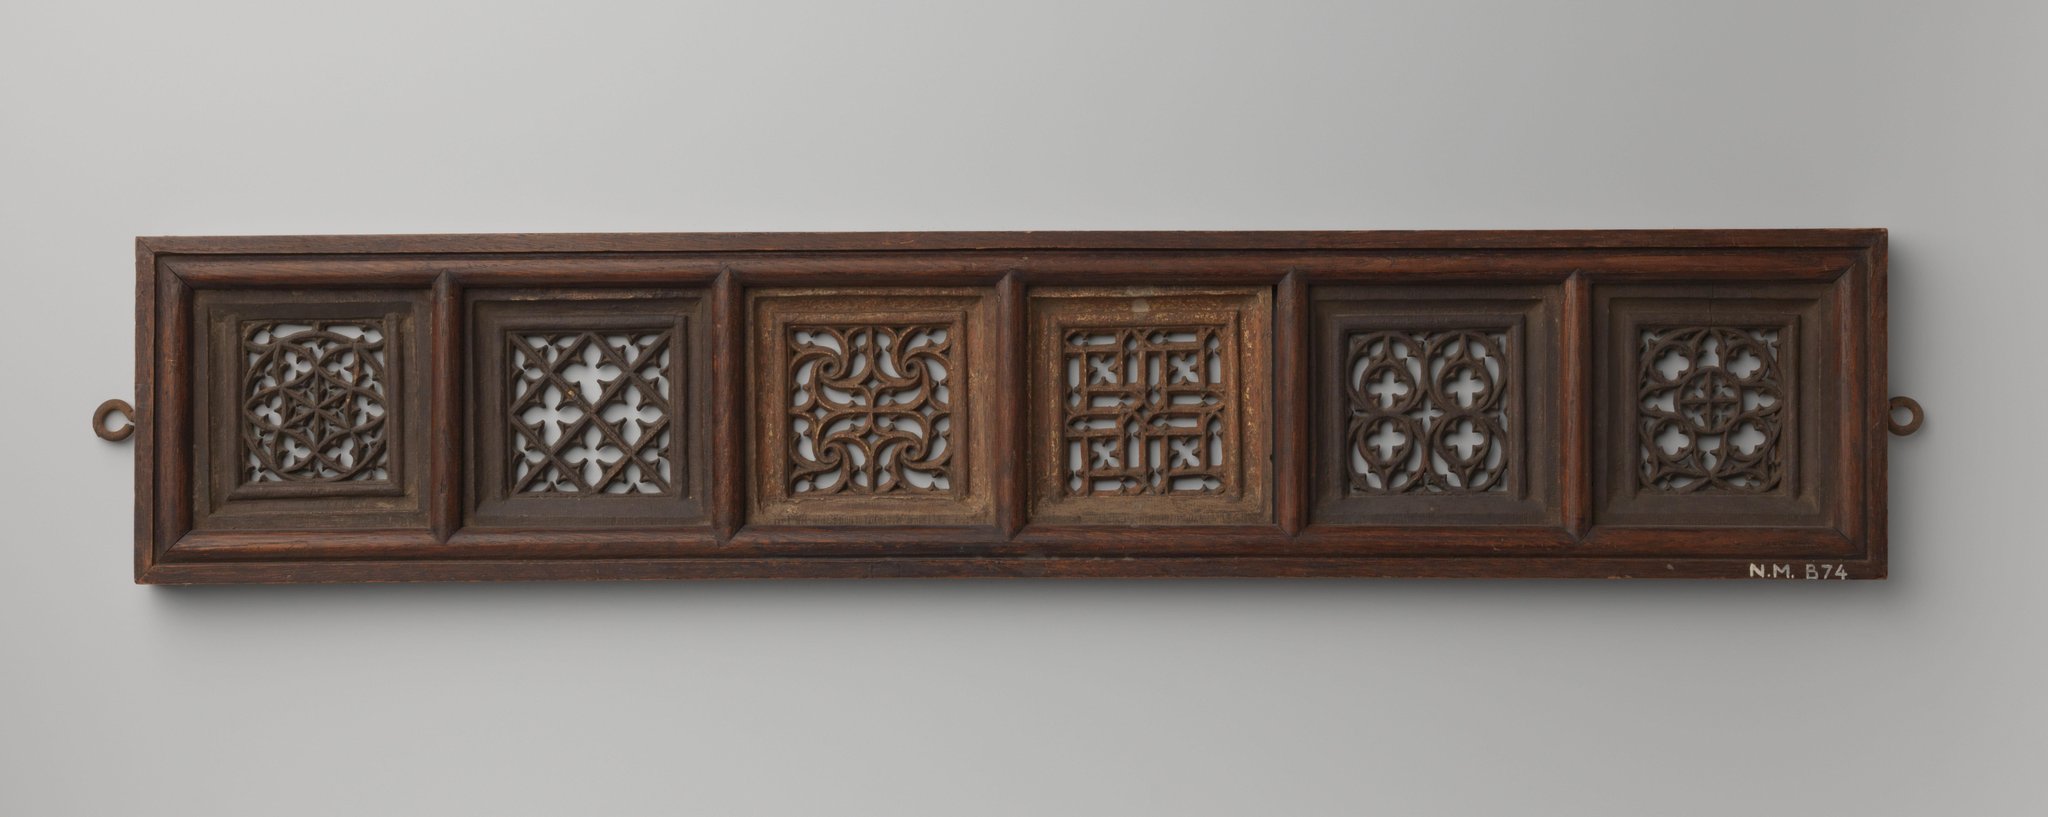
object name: panel surface component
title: Interieuronderdeel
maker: Anonymous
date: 1500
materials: wood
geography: low countries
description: Zes panelen van eikenhout met opengewerkte traceringen versierd. De panelen zijn vierkant en aan drie zijden door staafwerk omgeven. Het patroon wisselt. Onder een later opgebrachte bruine verflaag sporen van verguldsel. De panelen zijn voorzien van een moderne omraming.